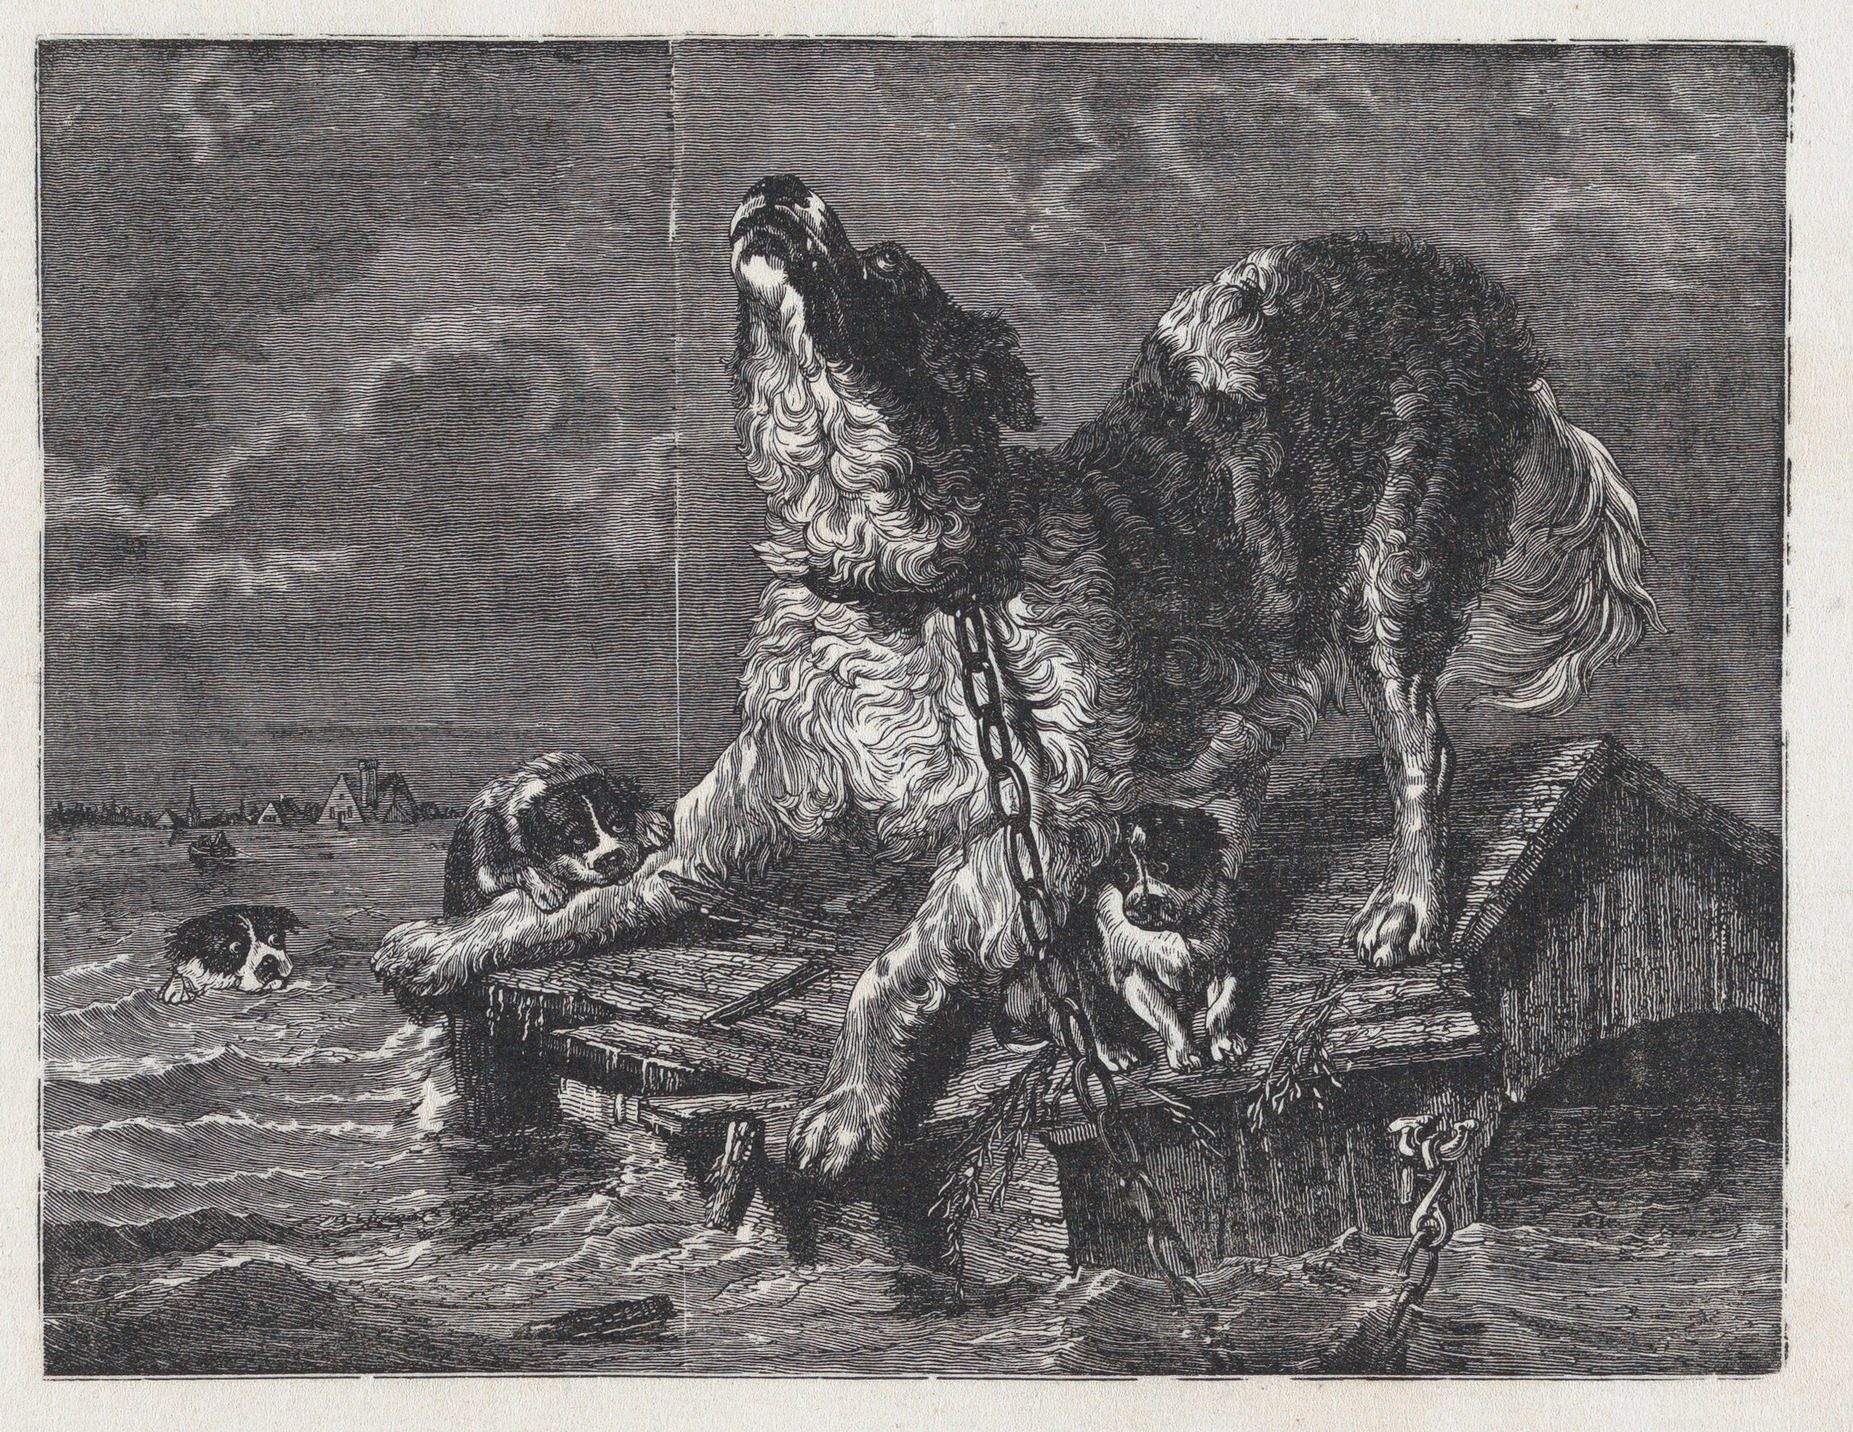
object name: print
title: A large chained dog howling while puppies try to climb onboard a sinking dog house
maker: miguel pacheco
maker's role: artist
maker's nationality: mexican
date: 1856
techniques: engraving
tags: dogs